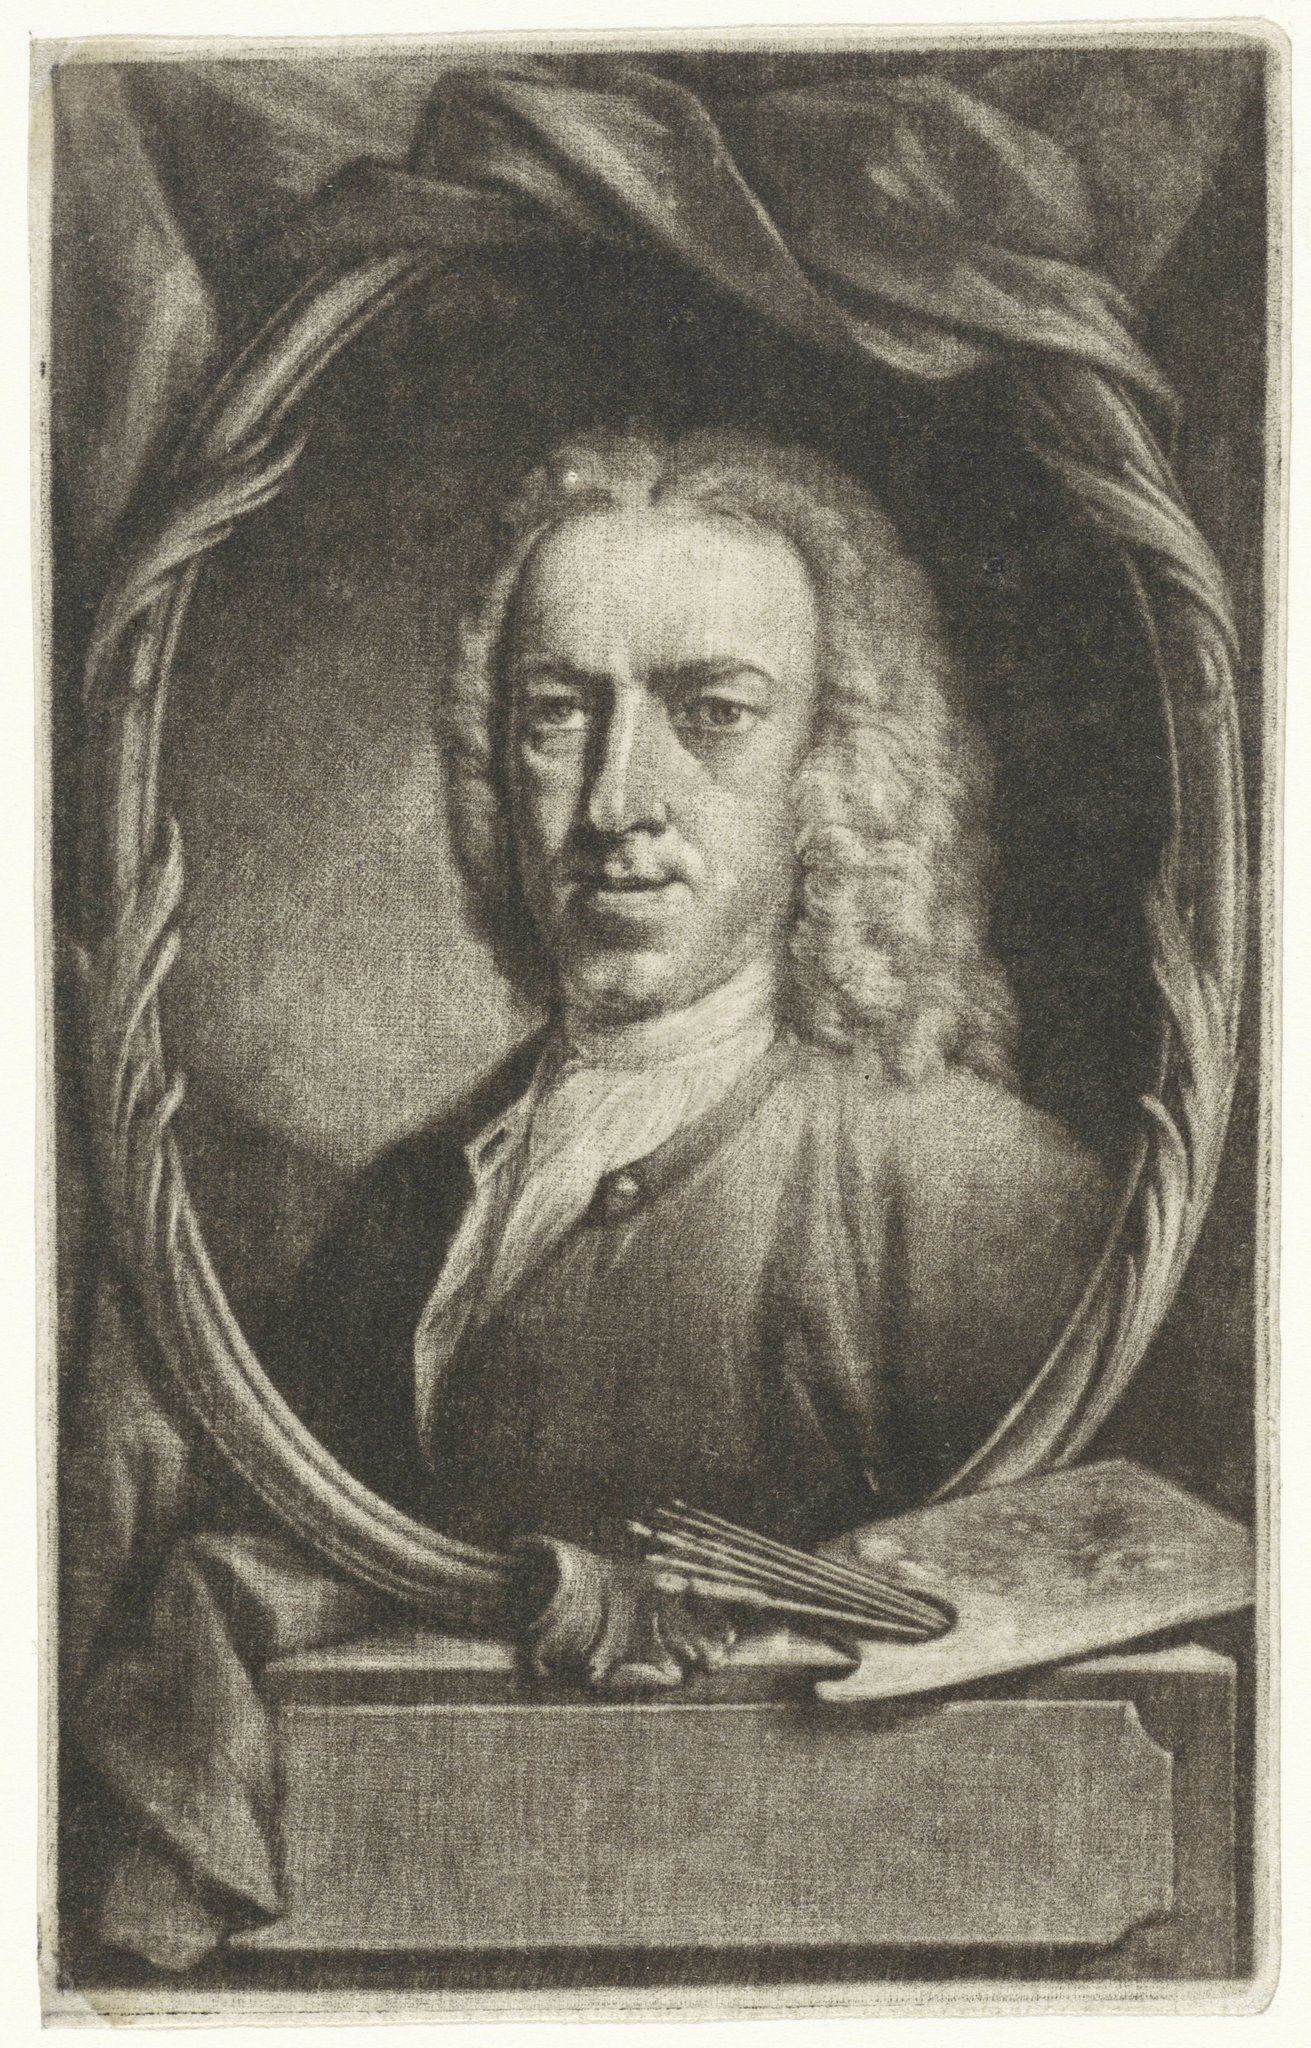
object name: print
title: Zelfportret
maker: aert schouman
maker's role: draughtsman, painter, print maker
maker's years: 1710-1792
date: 1740-1792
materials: paper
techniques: mezzotint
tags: dordrecht, the hague, painter, print maker, draughtsman, aert schouman, portrait, self-portrait of painter, tools, implements of painter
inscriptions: collector's mark: Lugt 2228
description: De schilder en prentmaker Aert Schouman. Buiten de omlijsting liggen penselen en een palet.